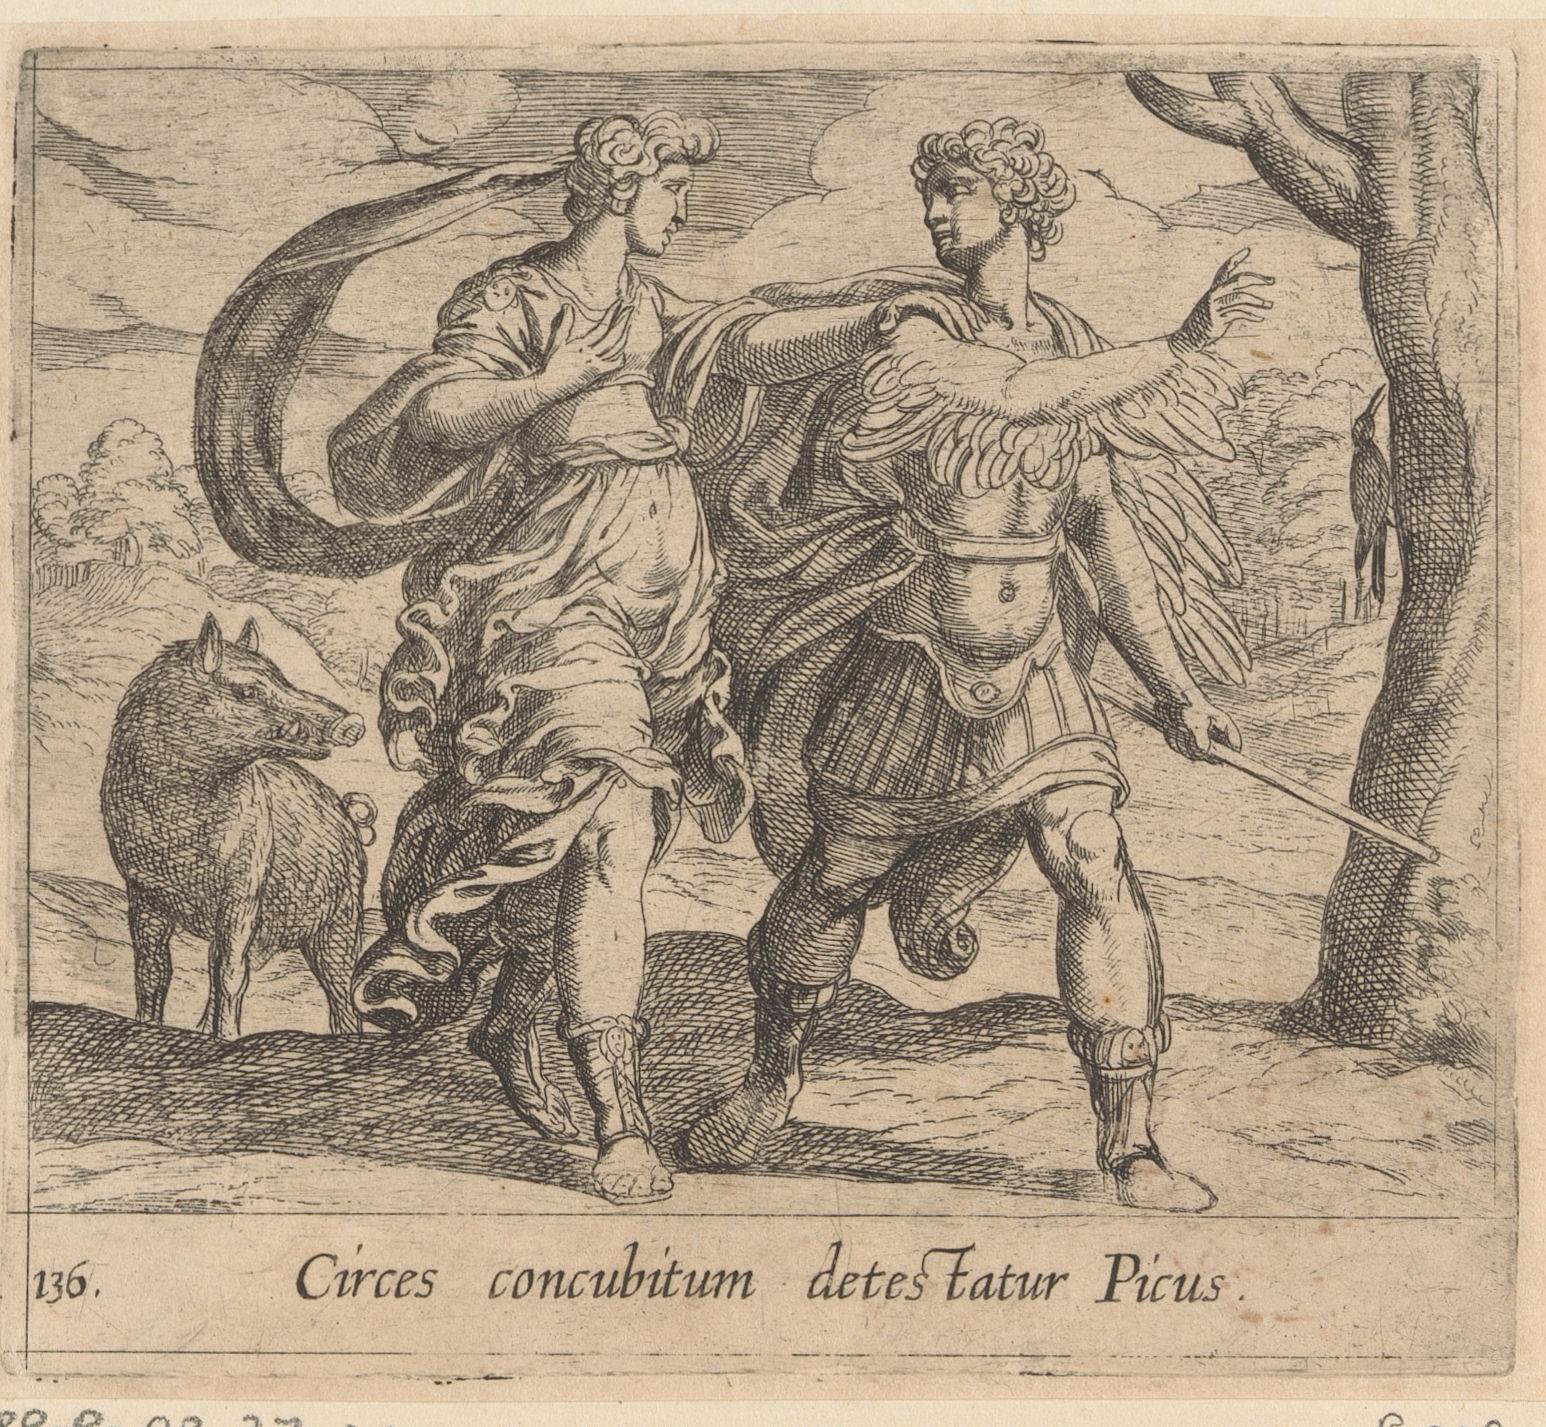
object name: print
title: Circe verandert Picus in een vogel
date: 1606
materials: paper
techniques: etching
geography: antwerp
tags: picus changed into a woodpecker: circe changes picus into a woodpecker because, faithful to his wife canens, he spurns the love of the goddess (ovid, metamorphoses xiv 386)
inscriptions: collector's mark: Lugt 240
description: Deze prent maakt deel uit van een reeks van 150 prenten (+ titelprent) met voorstellingen van de Metamorfosen van Ovidius.